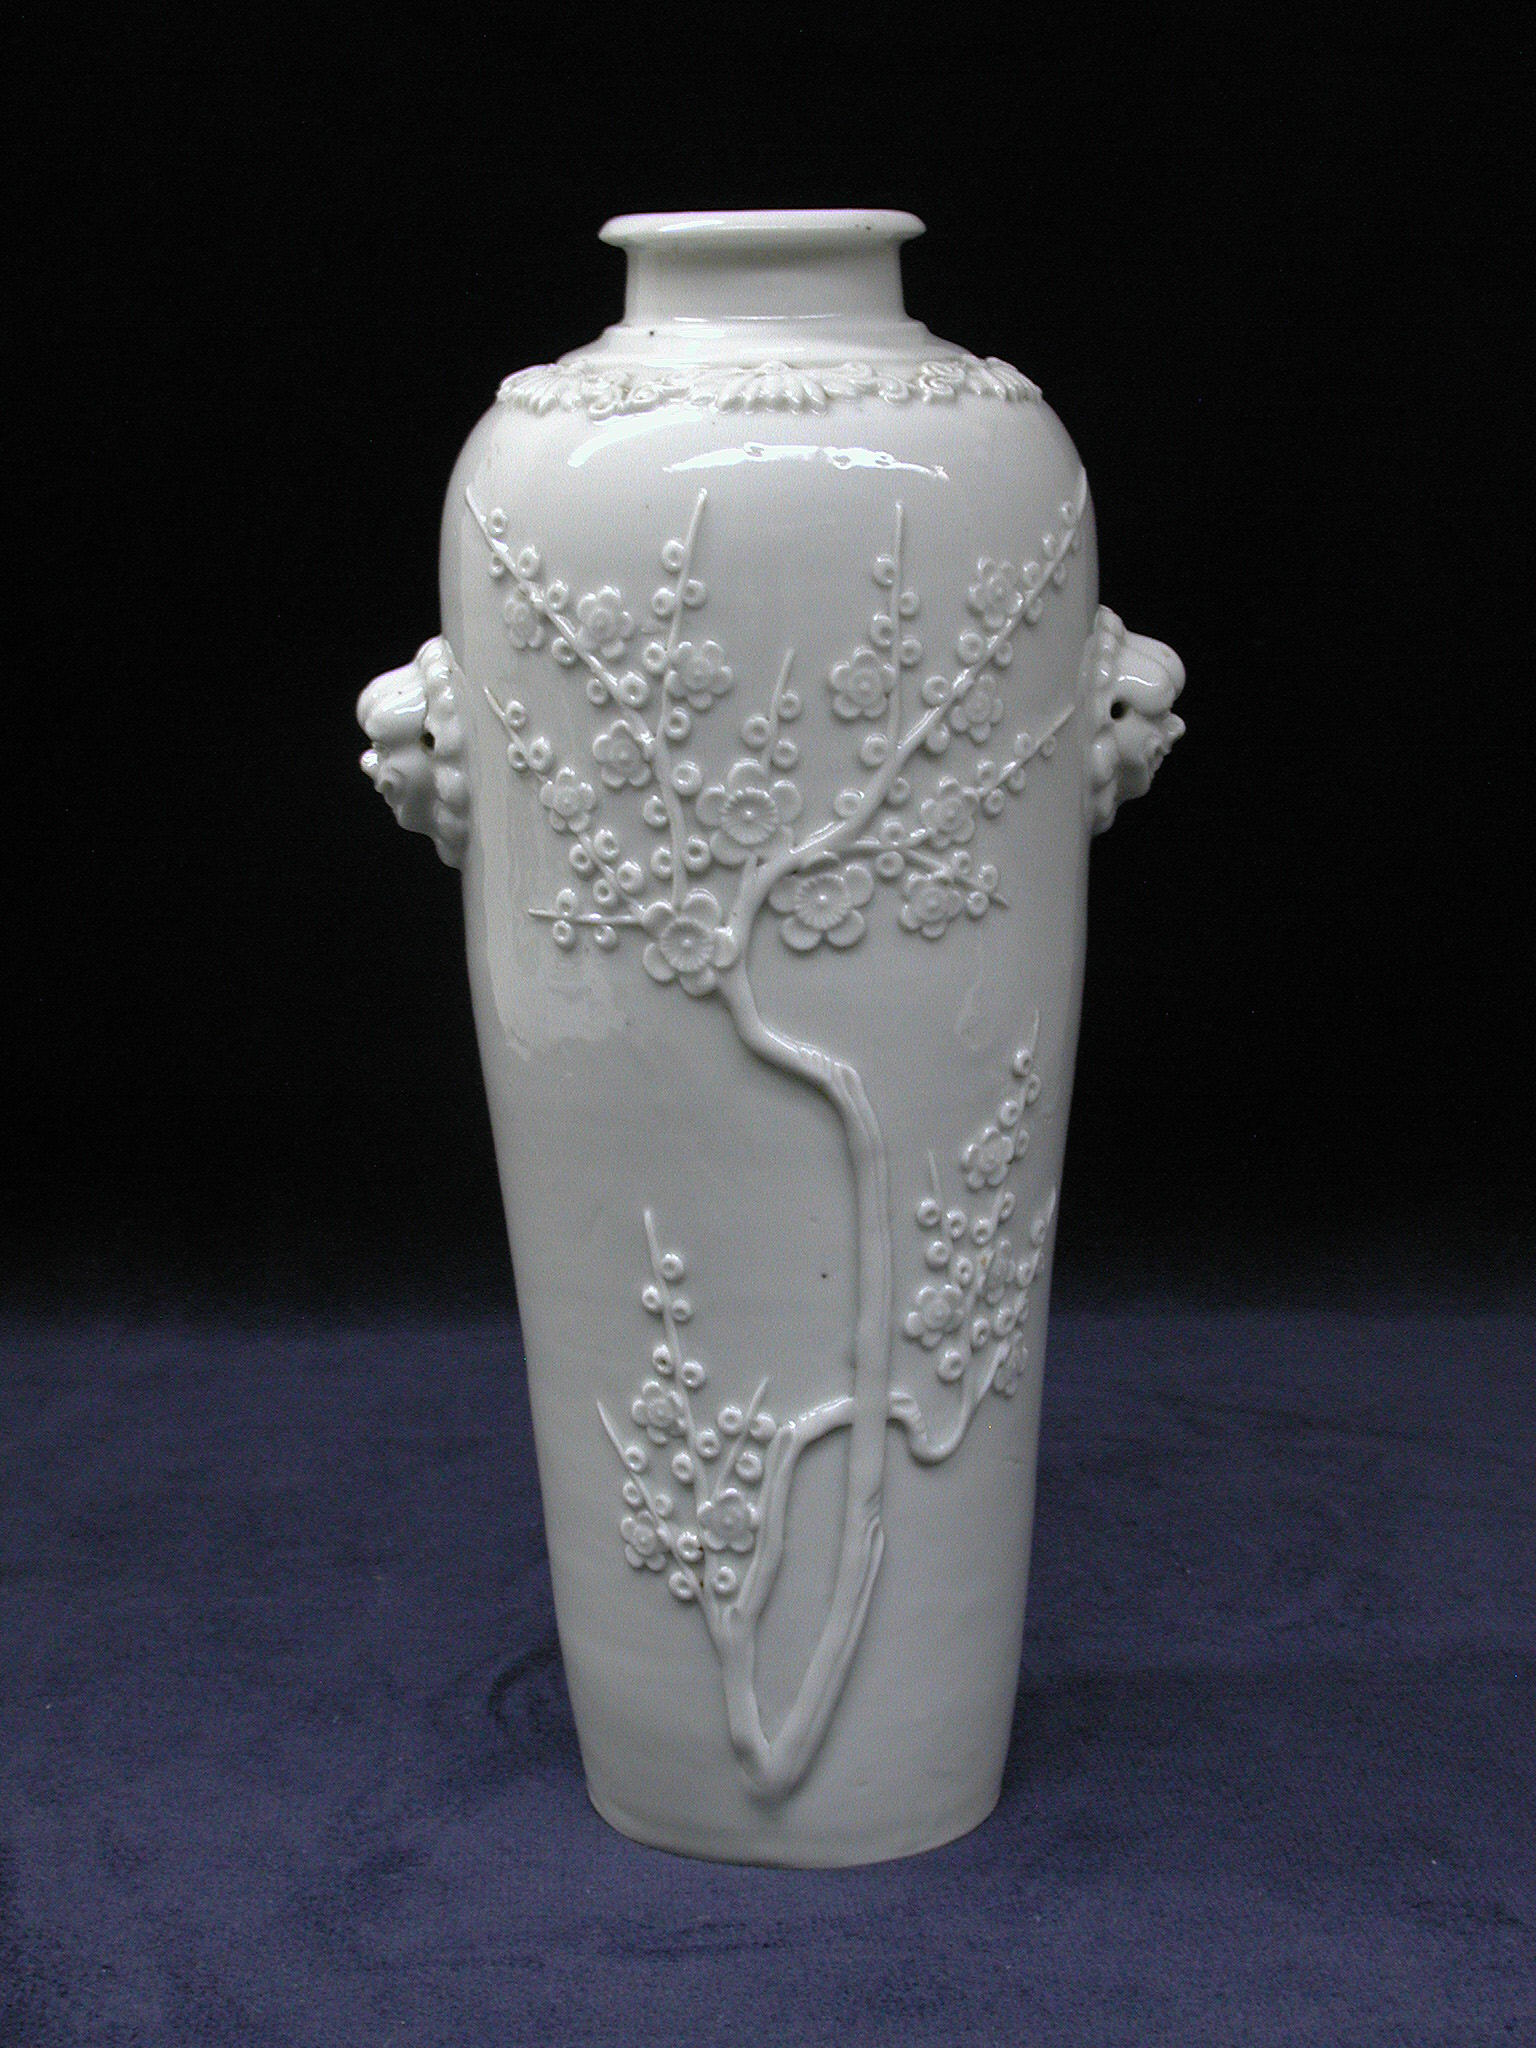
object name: vase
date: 1767-1800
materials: hard paste porcelain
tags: flowers,trees